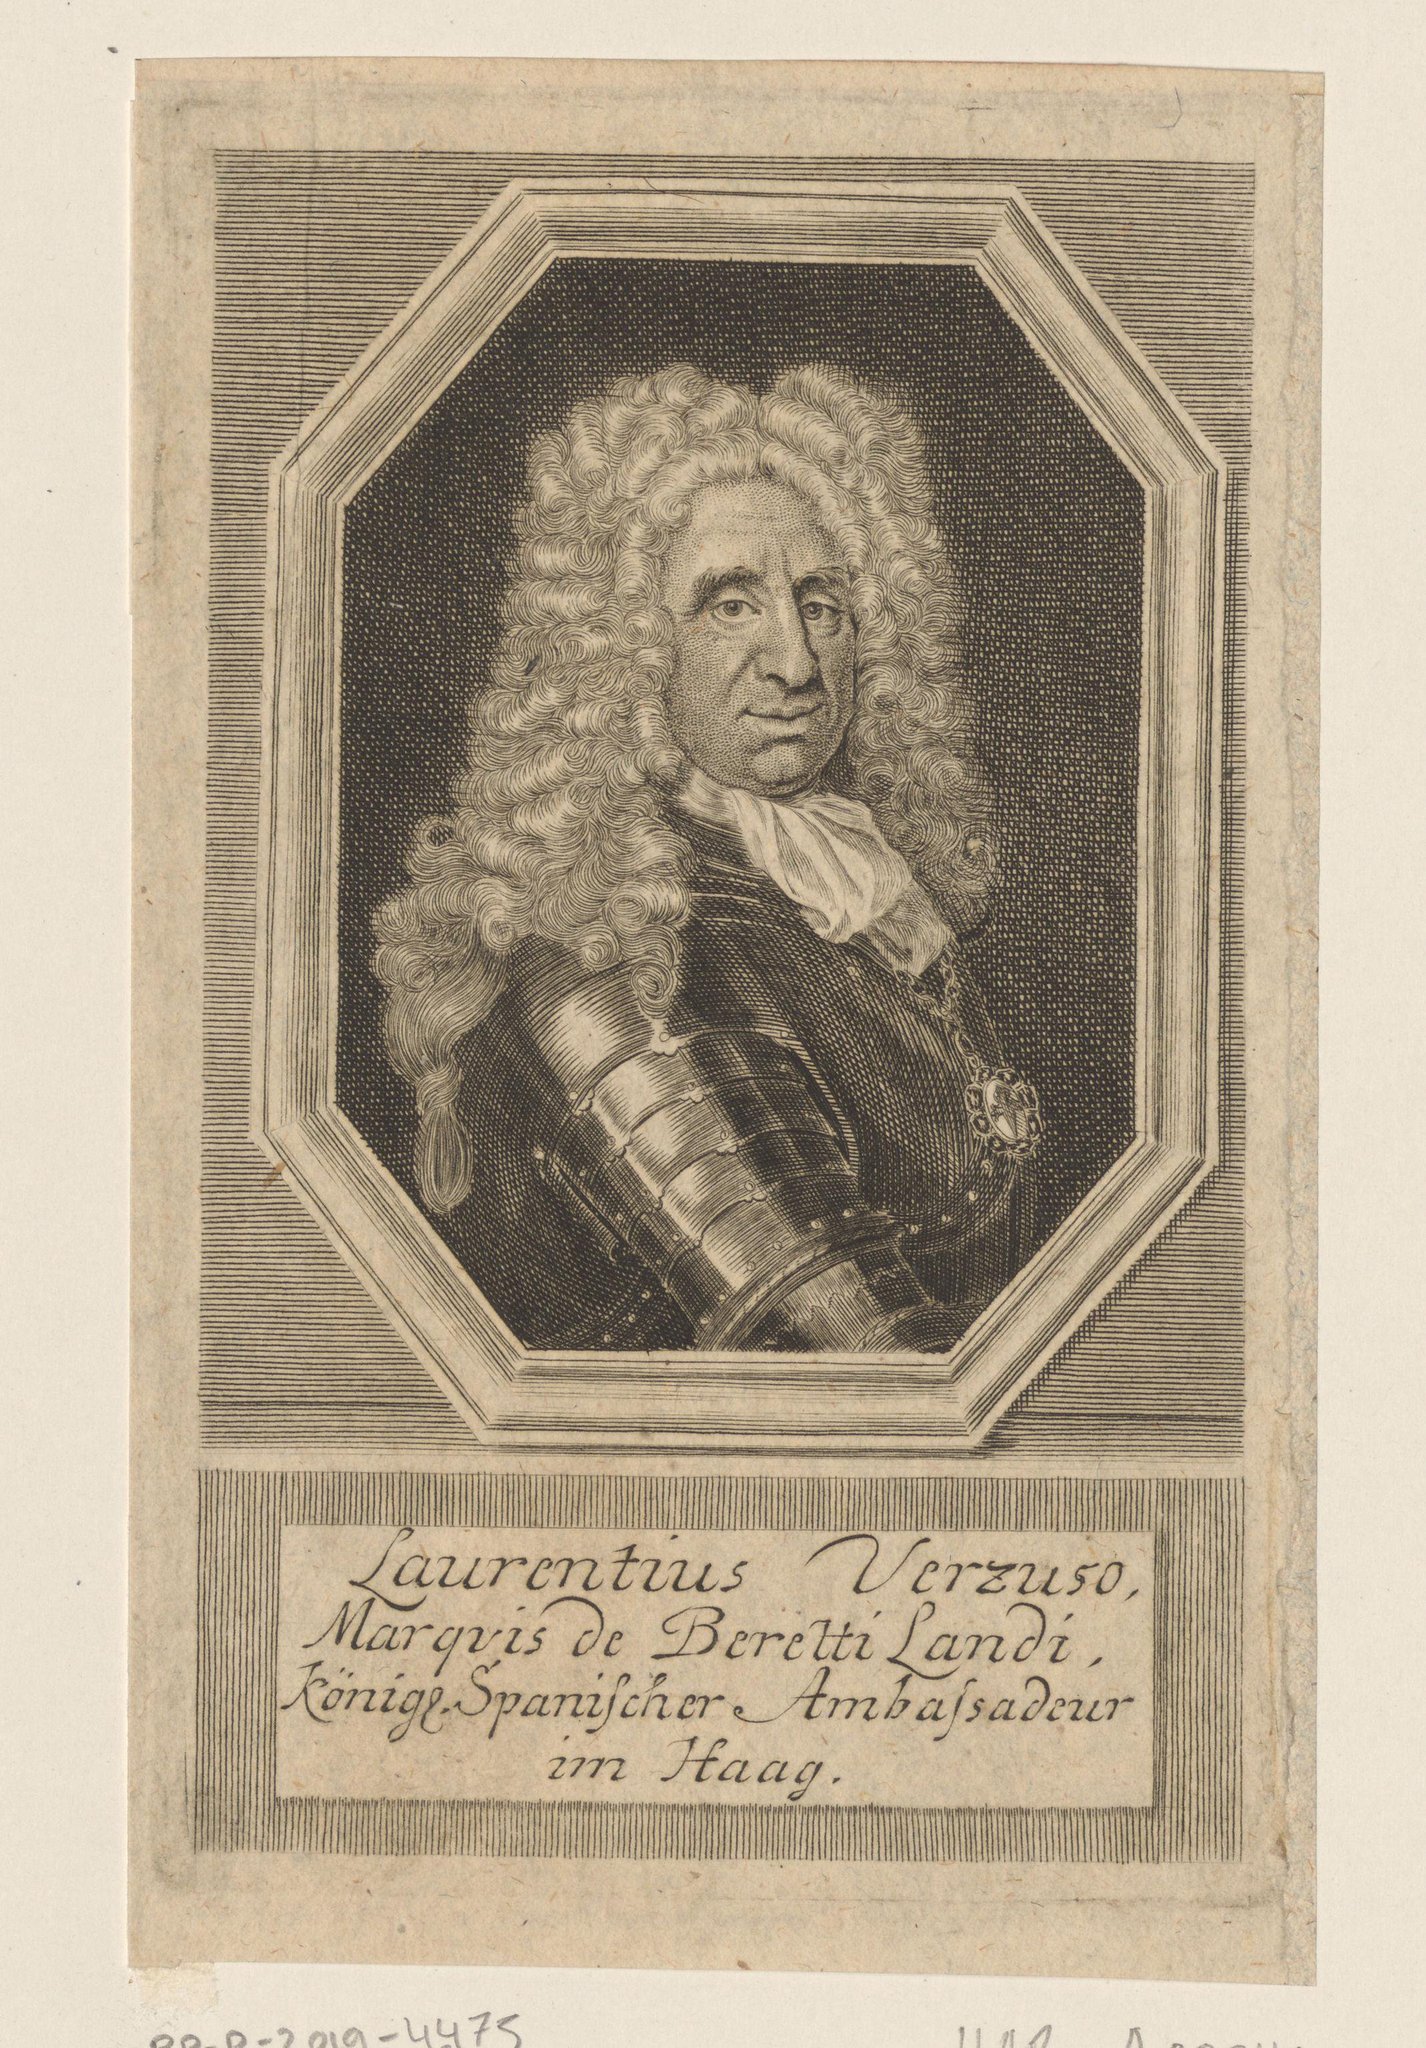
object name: print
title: Portret van Lorenzo di Vergiuso, markies van Beretti-Landi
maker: martin bernigeroth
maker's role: print maker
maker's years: 1670-1733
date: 1720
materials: paper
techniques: engraving, etching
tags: armour, historical persons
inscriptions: collector's mark: Lugt 2228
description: Prent uit: Die europäische Fama, welche den gegenwärtigen Zustand der vornehmsten Höfe entdecket. [Leipzig]: s.n., 1720, dl. 237.